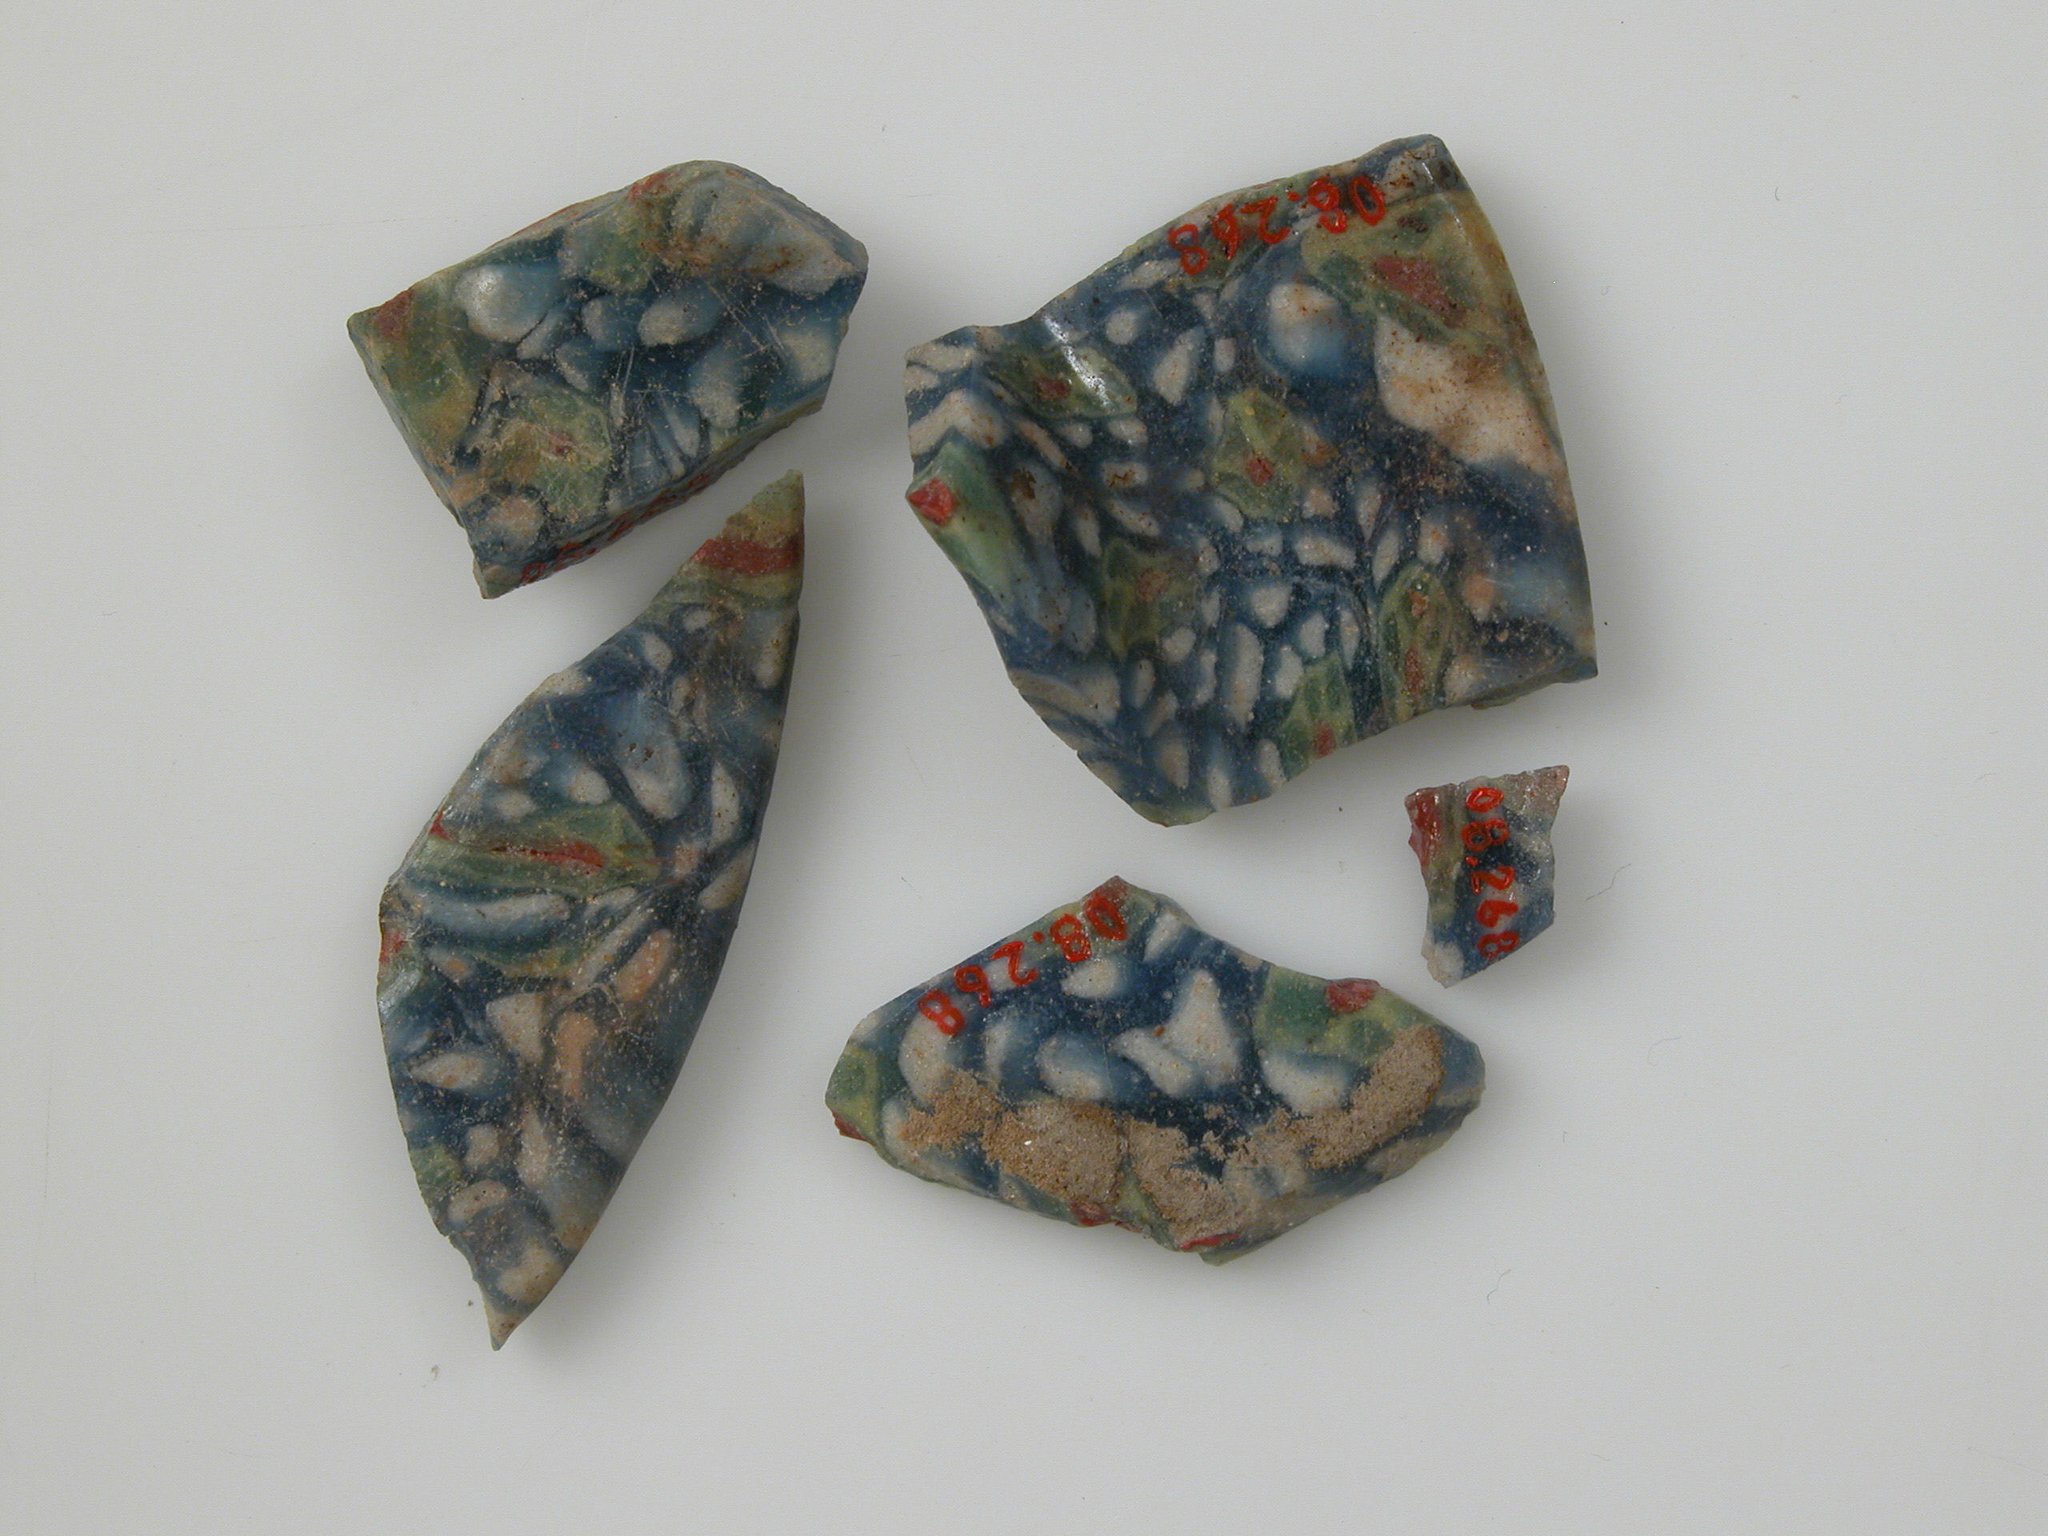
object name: fragment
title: Glass Fragments from a Vessel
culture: coptic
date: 301-433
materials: glass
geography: egypt